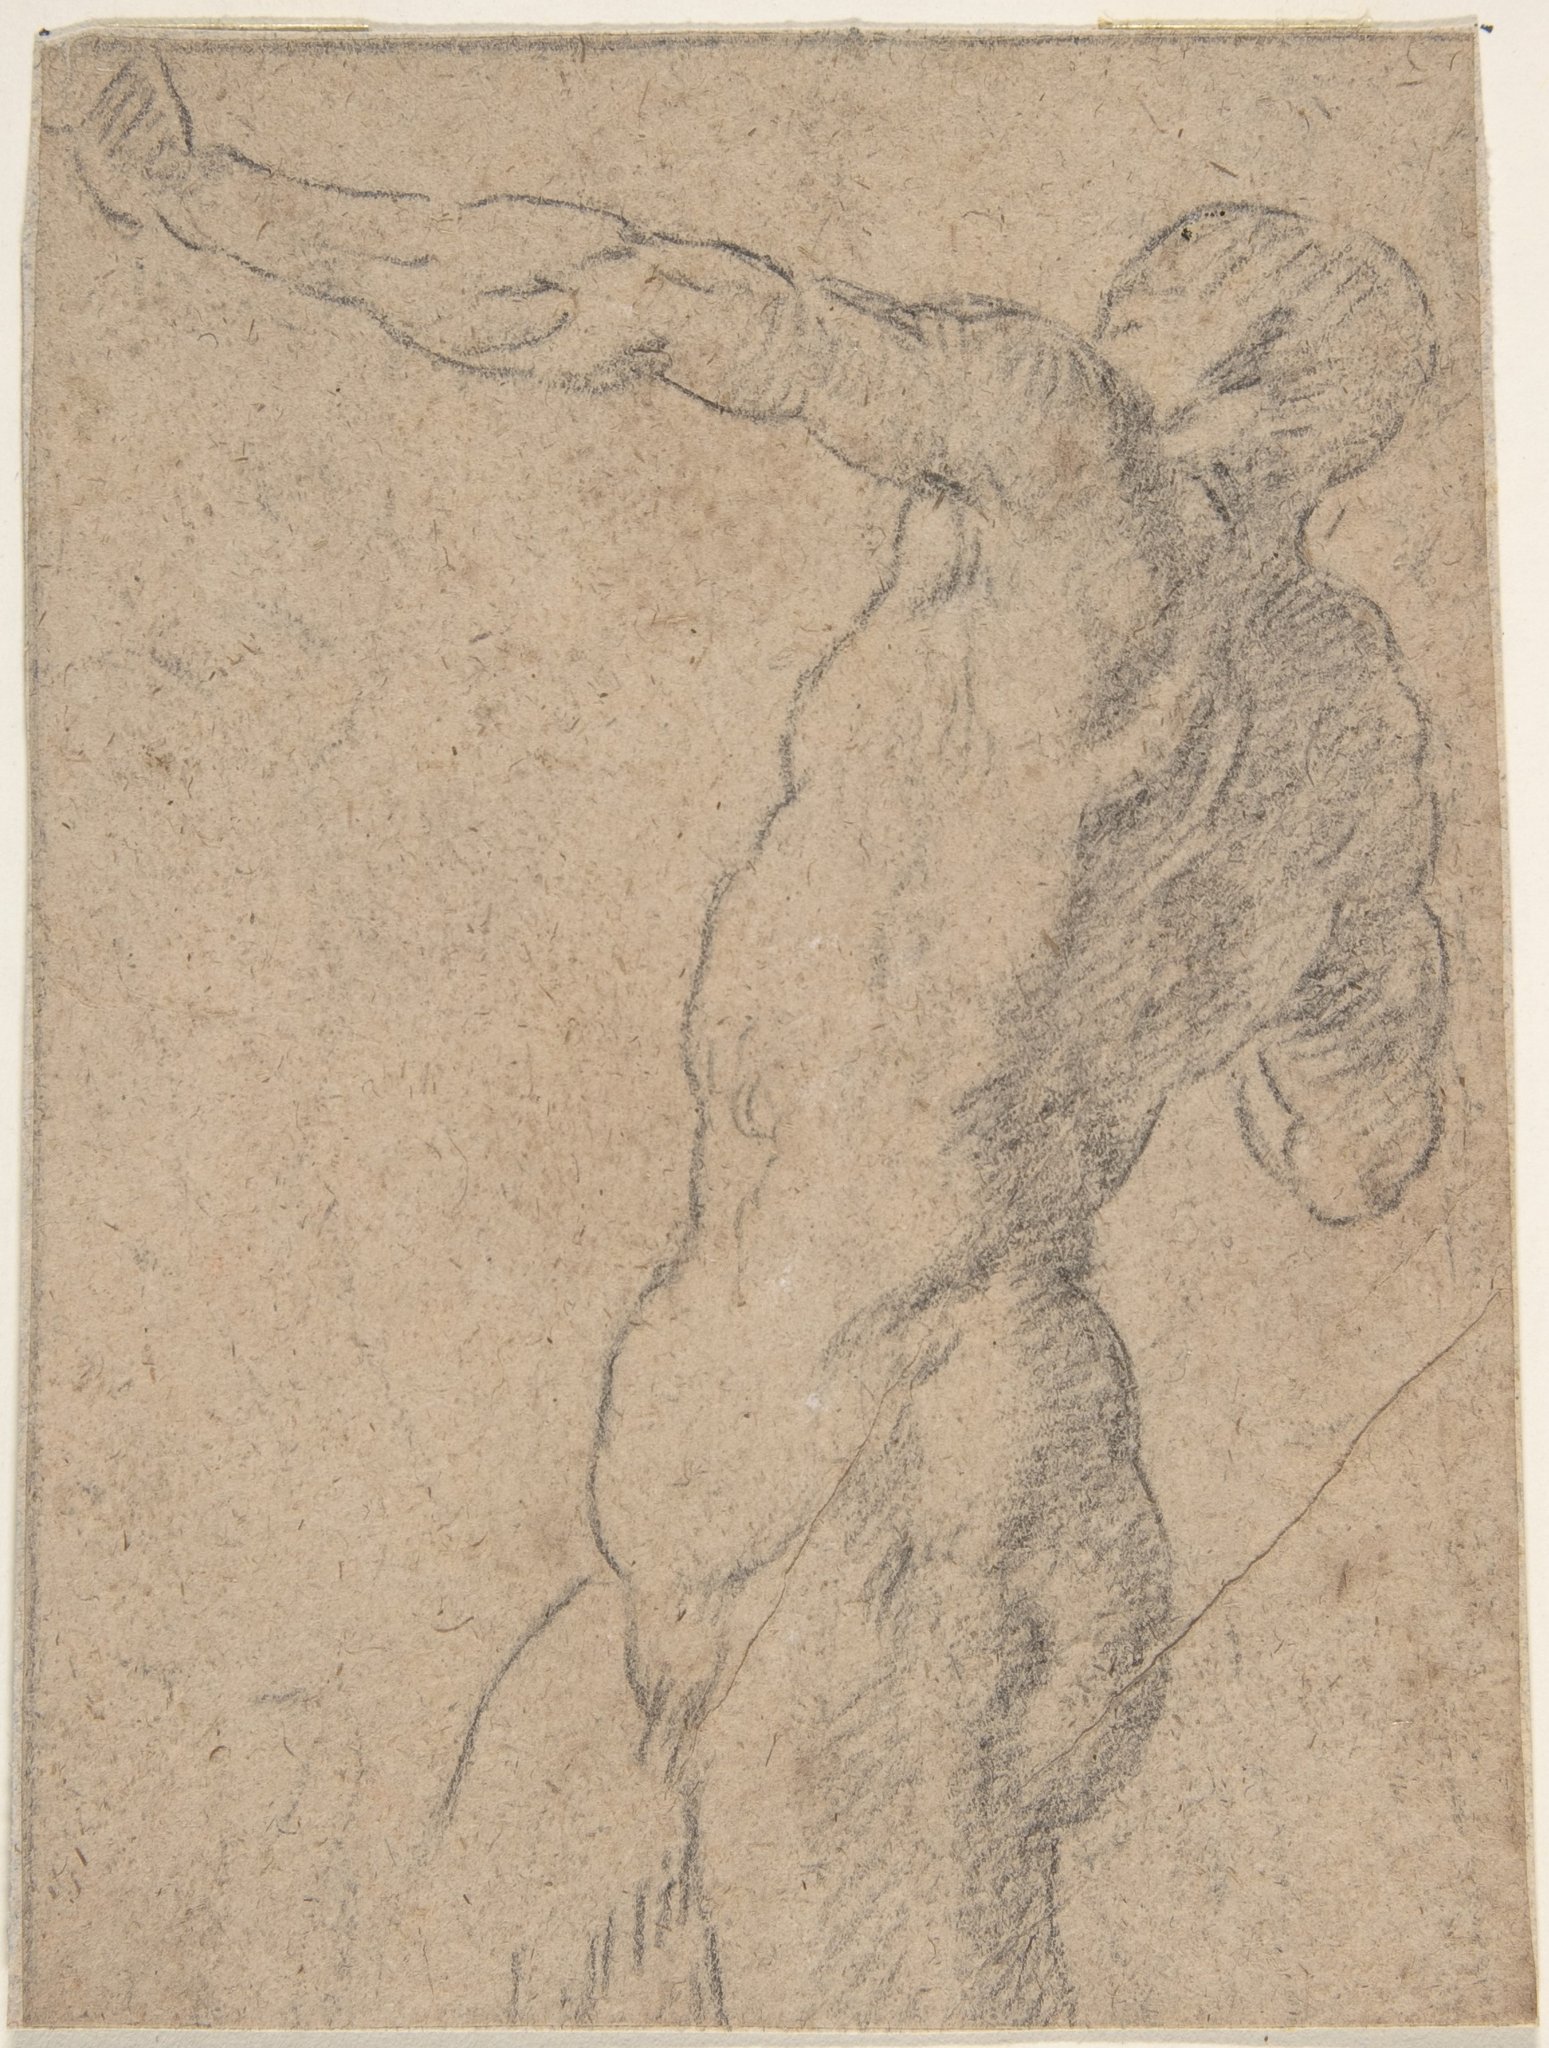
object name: drawing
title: Life Study of Standing Male Nude in Three-Quarter Length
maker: anonymous, spanish, school of seville, 17th century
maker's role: artist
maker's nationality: spanish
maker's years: 1600-1700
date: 1601-1700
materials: chalk, paper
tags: male nudes